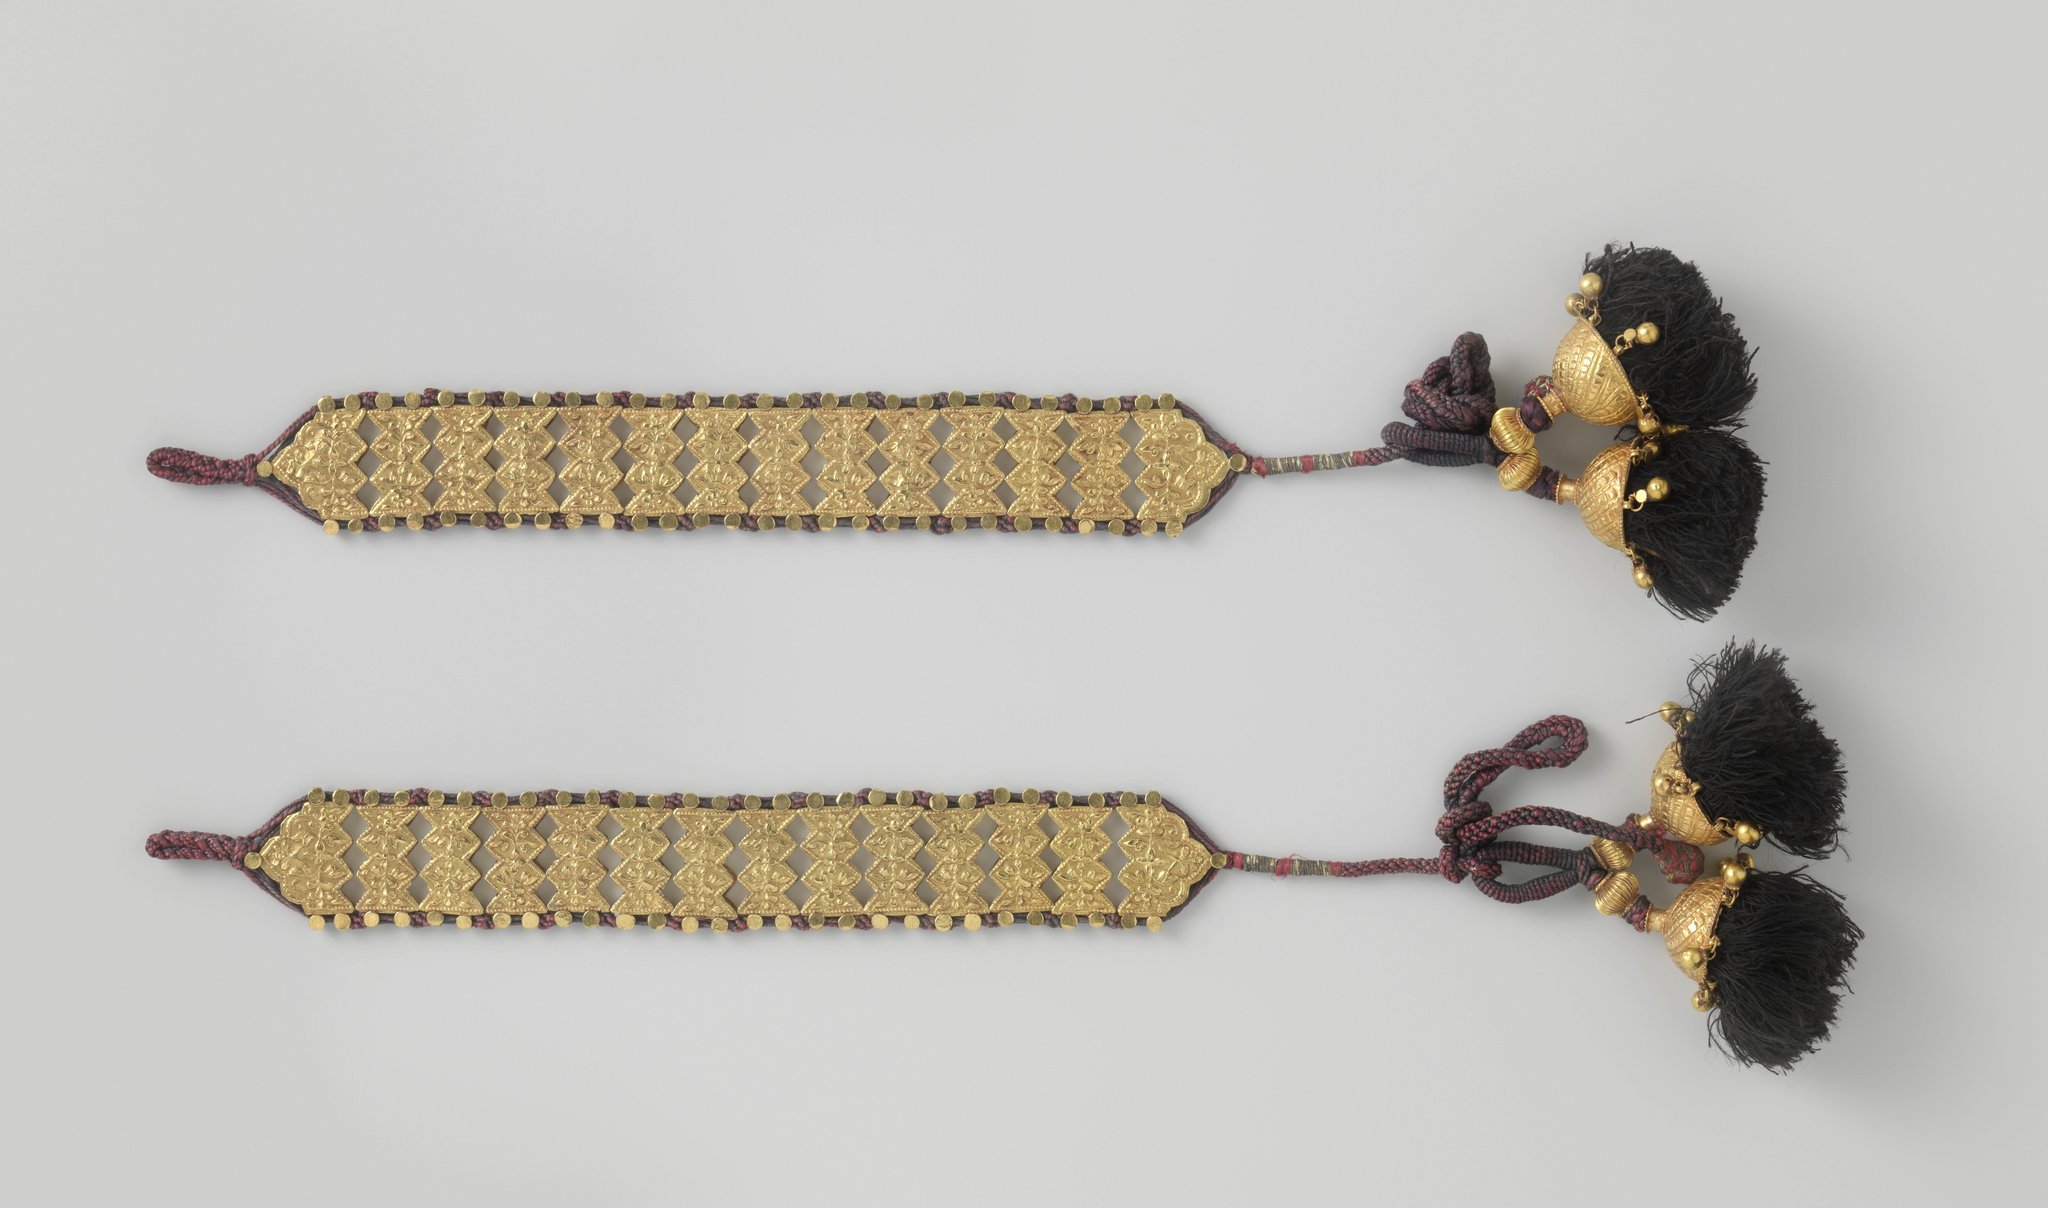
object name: jewellery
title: Pair of upper arm bracelets (baju bandh)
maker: Anonymous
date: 1750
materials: gold, silver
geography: surat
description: Een paar bovenarmbanden (baju bandh) bestaande uit schakels van goud repoussé in zigzag-vorm, geregen aan een donkerpaars zijden koord. Aan één van de uiteinden hangen met goud versierde kwastjes.